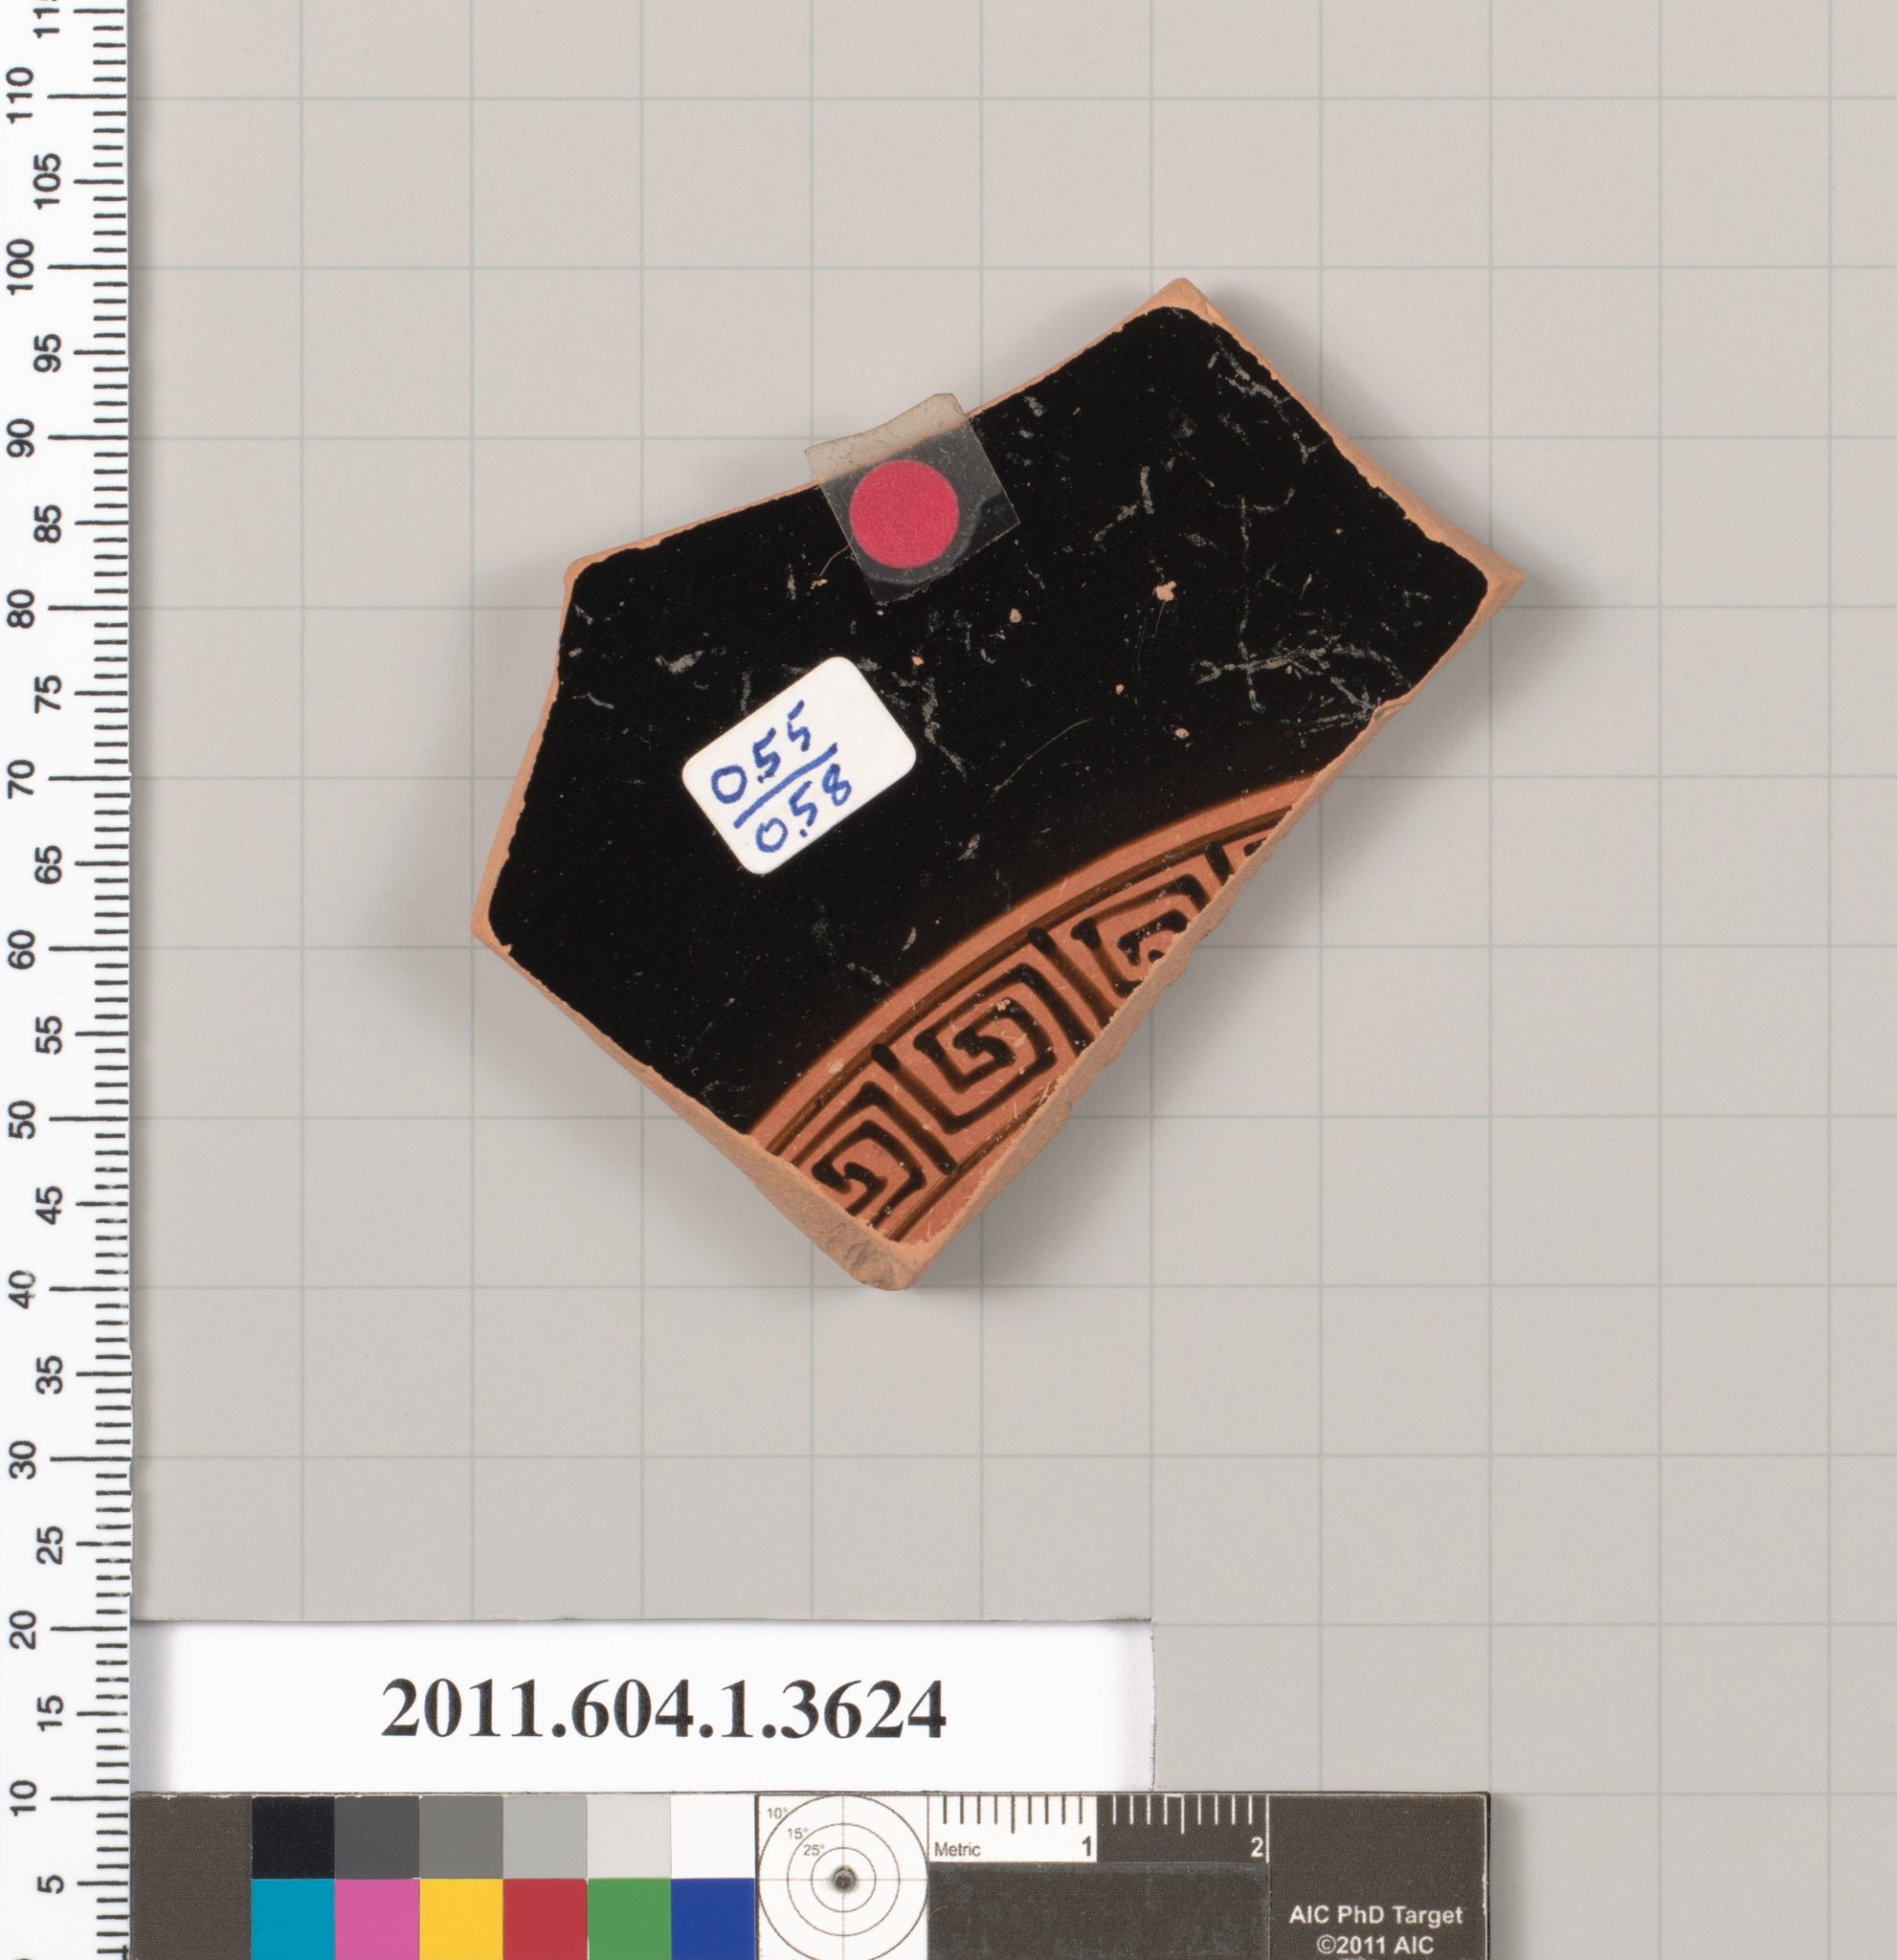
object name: kylix fragment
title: Terracotta fragment of a kylix (drinking cup)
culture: greek, attic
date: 475-451 BCE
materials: terracotta